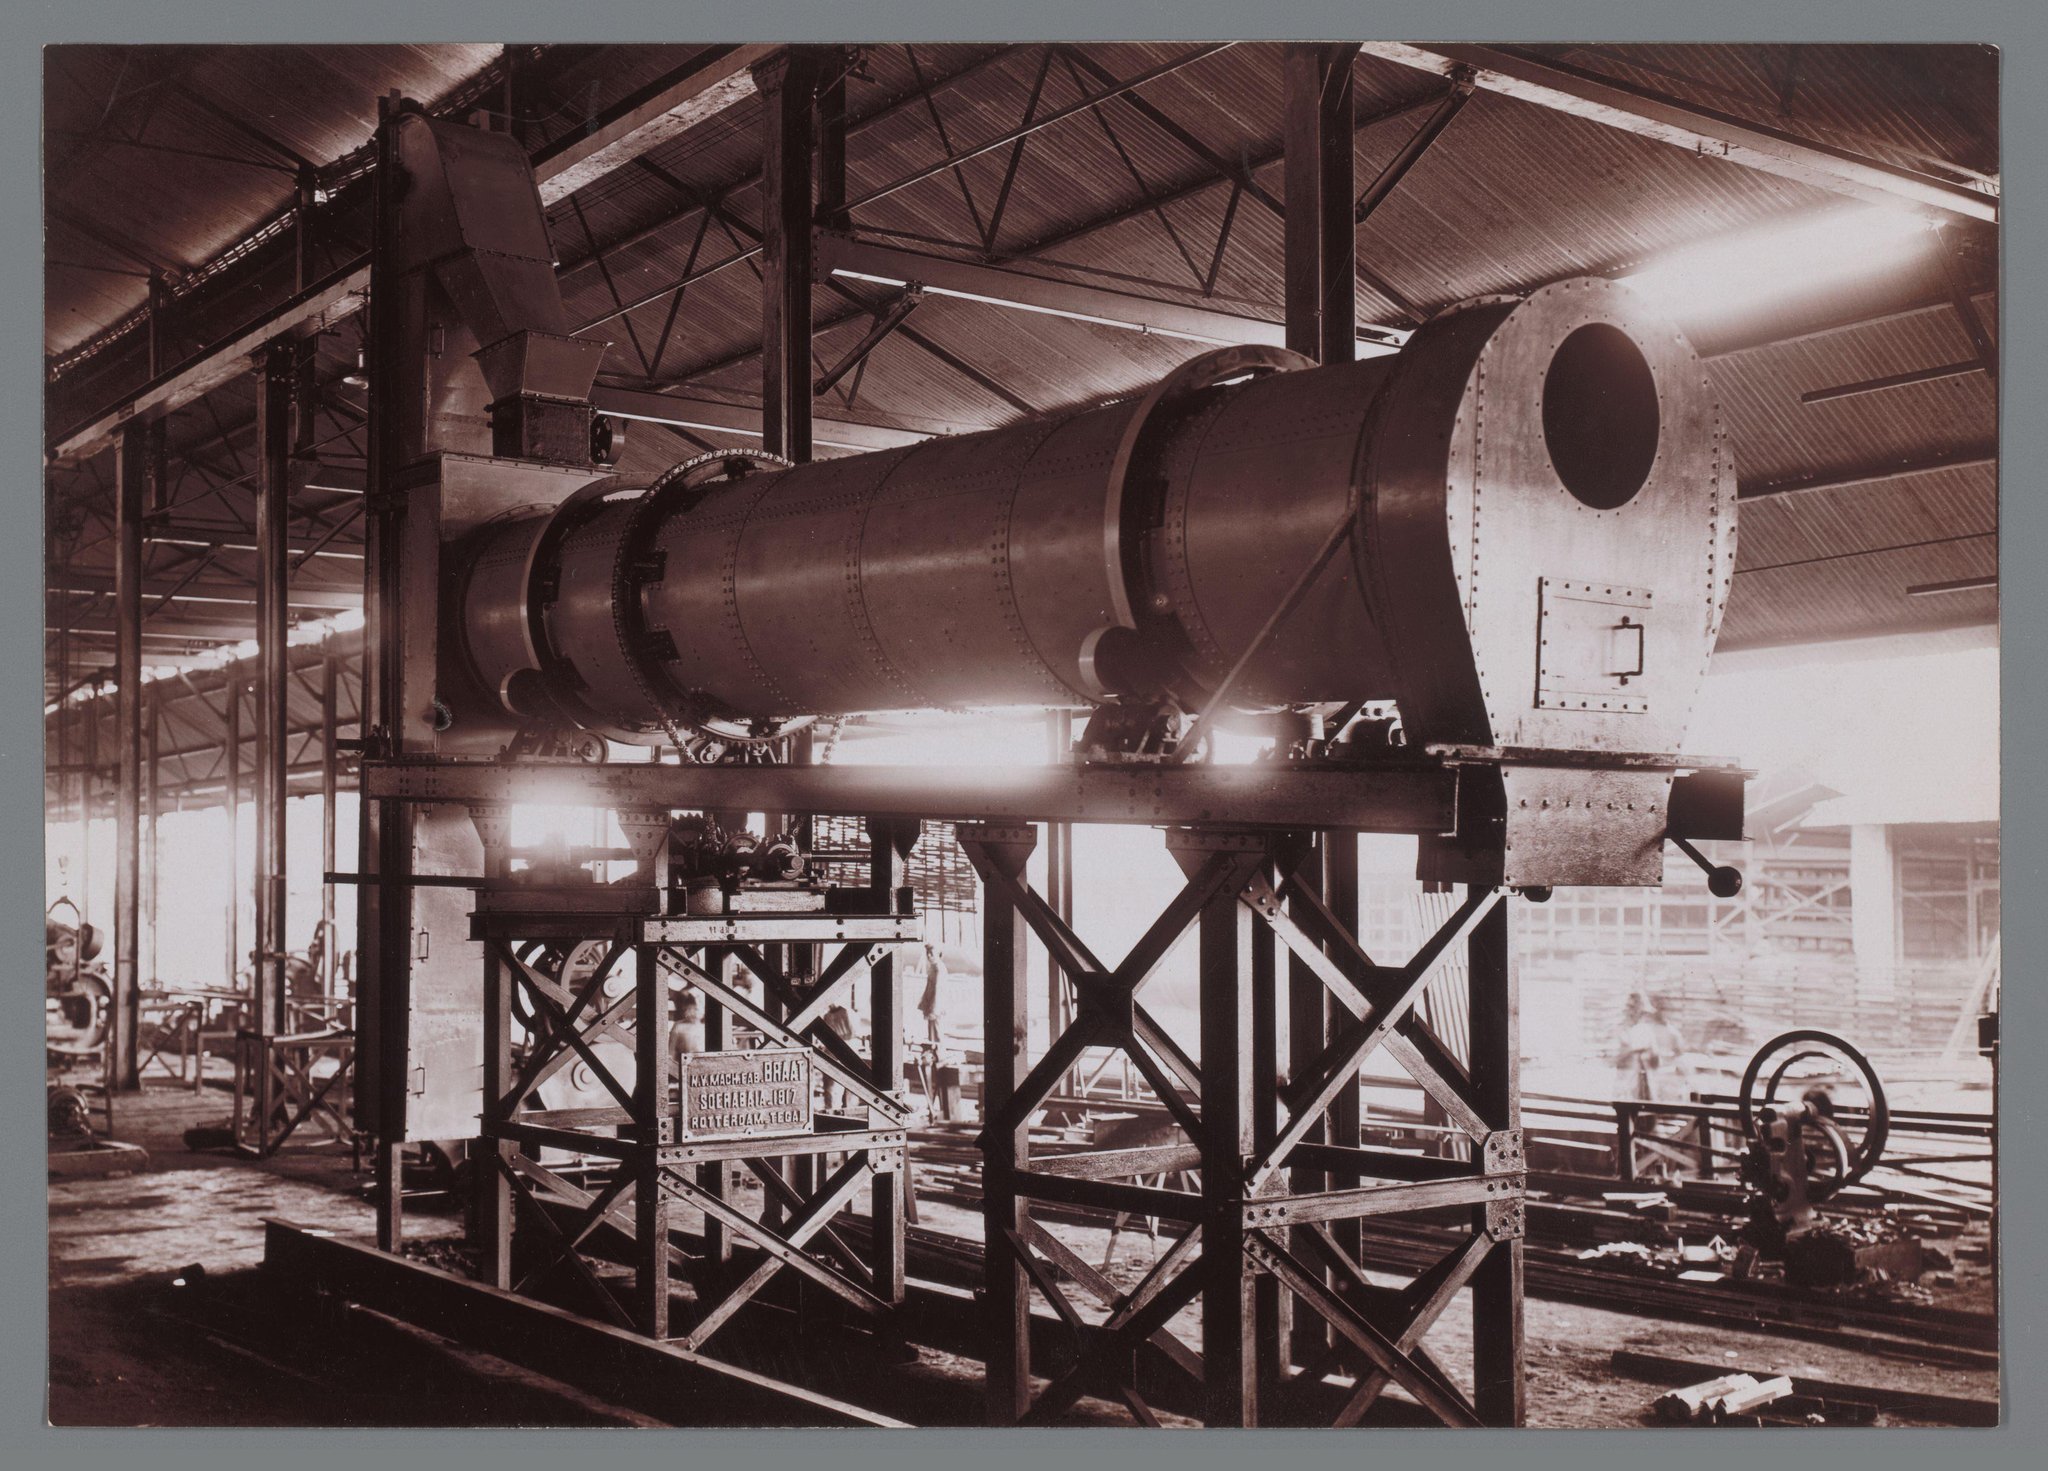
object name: photograph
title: Suikerdrooginstallatie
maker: Anonymous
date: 1902-1918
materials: photographic support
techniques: gelatin silver print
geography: surabaya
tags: colonial system, factory-interior, machine shop, machines; parts of machines; tools and appliances, (non-fruit) products of plants or trees: sugarcane, java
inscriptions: date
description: Suikerdroger vervaardigd in 1917 voor de Suikerfabriek Manishardjo ten noordoosten van Klaten op Java. Onderdeel van de multomap met foto's van machines van de N.V. Machinefabriek Braat te Soerabaja bestemd voor de Nederlandse suikerindustrie op Java, uit de periode 1917-1938.